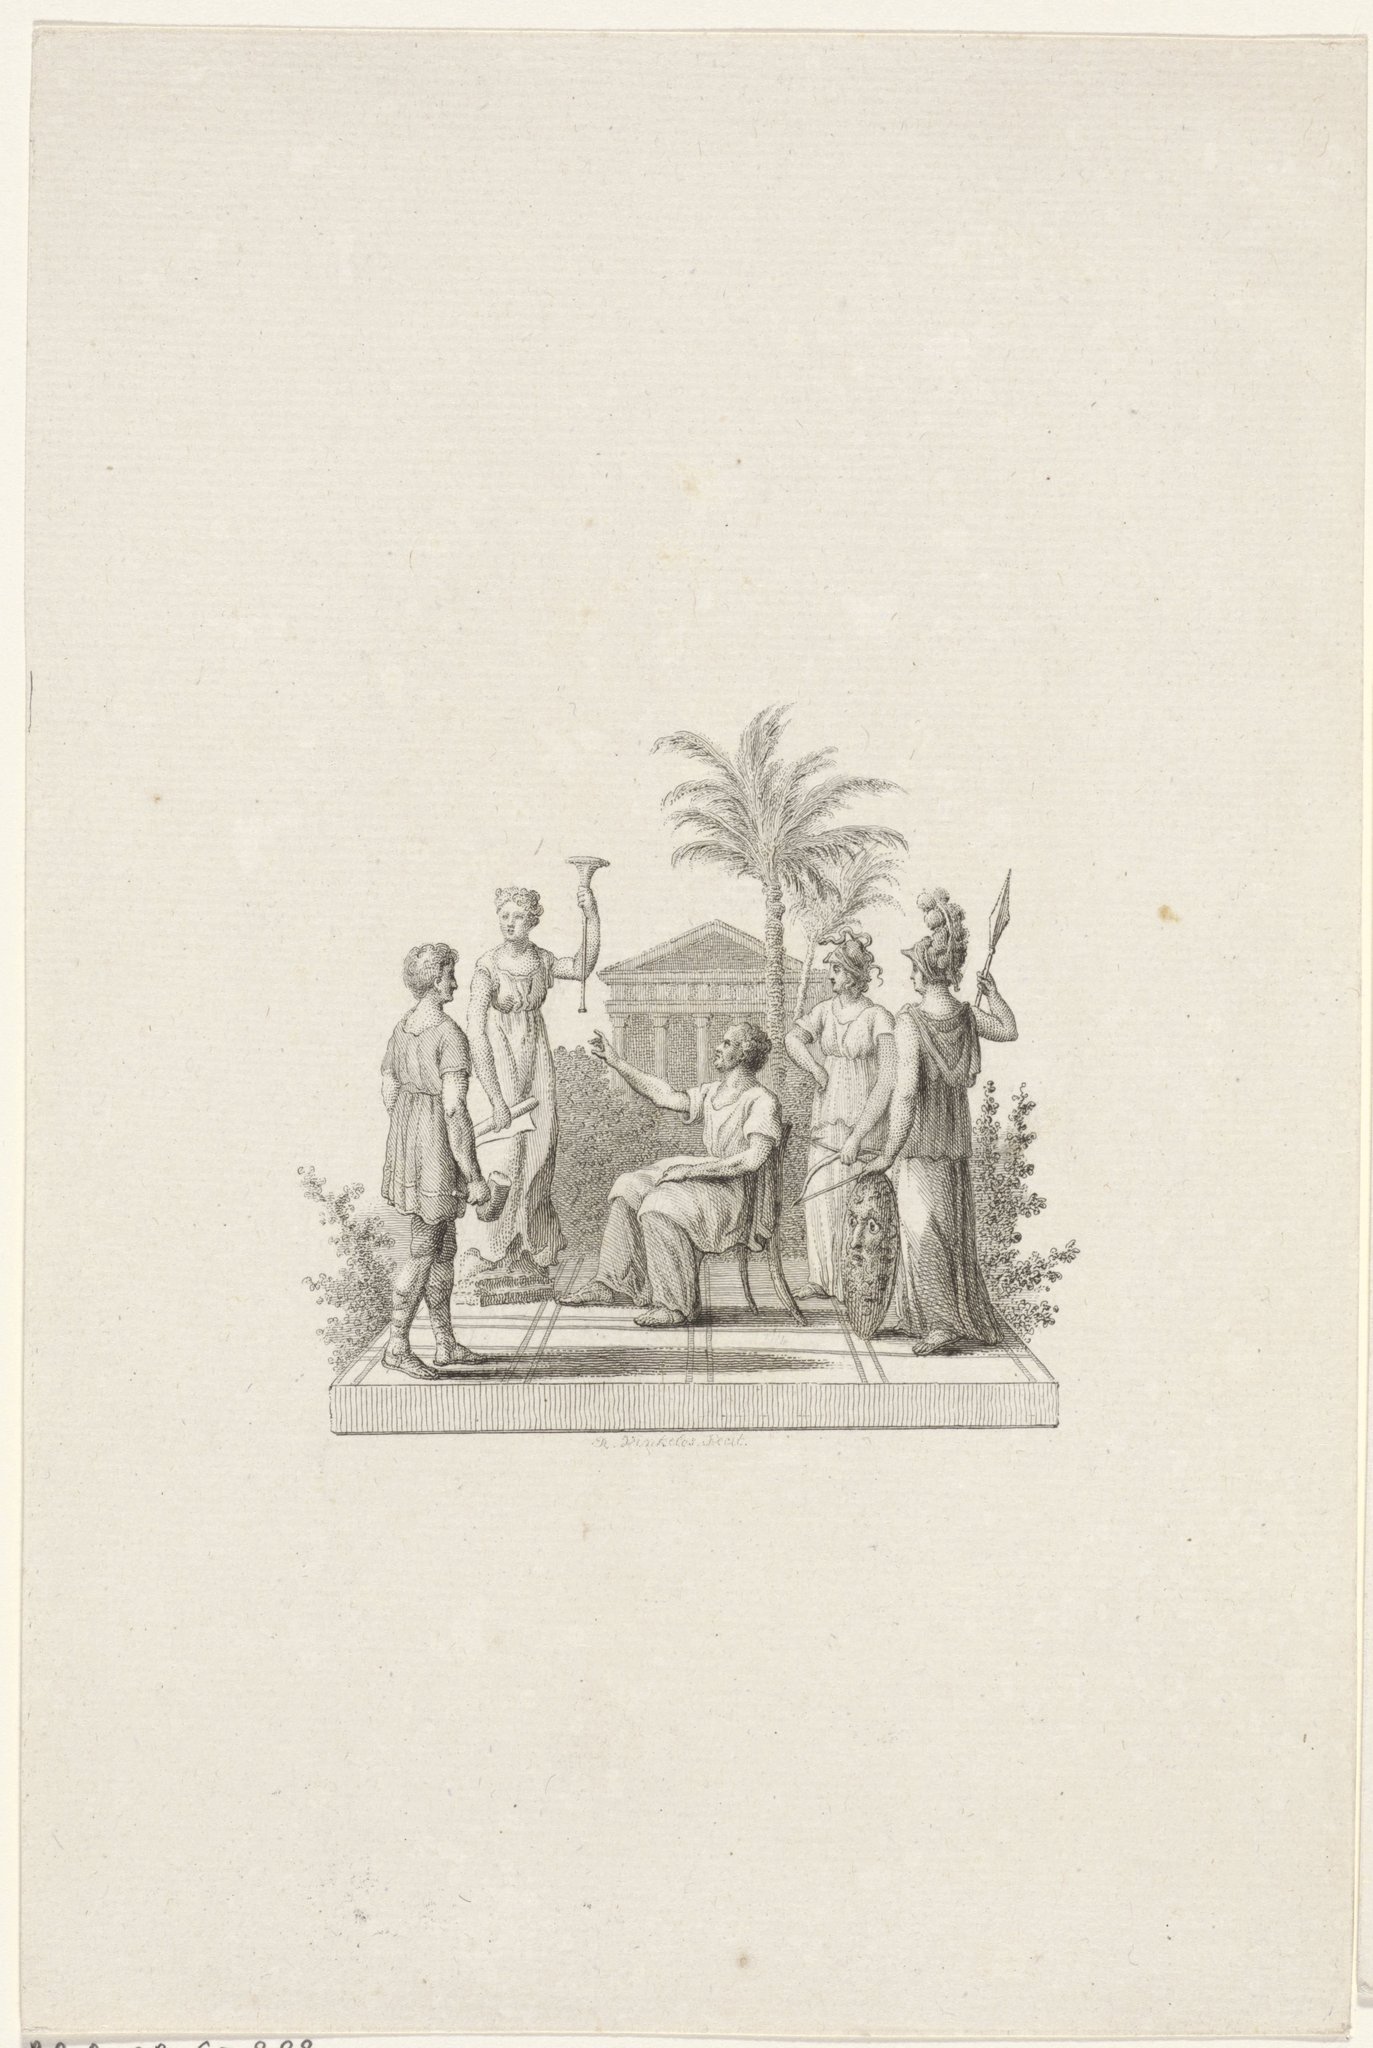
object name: print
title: Zittende man omringd door vier staande figuren met attributen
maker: reinier vinkeles (i)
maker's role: draughtsman, print maker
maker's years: 1741-1816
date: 1751-1816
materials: paper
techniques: engraving, etching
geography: amsterdam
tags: weapons, temple, shrine ~ greek religion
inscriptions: collector's mark: Lugt 2228